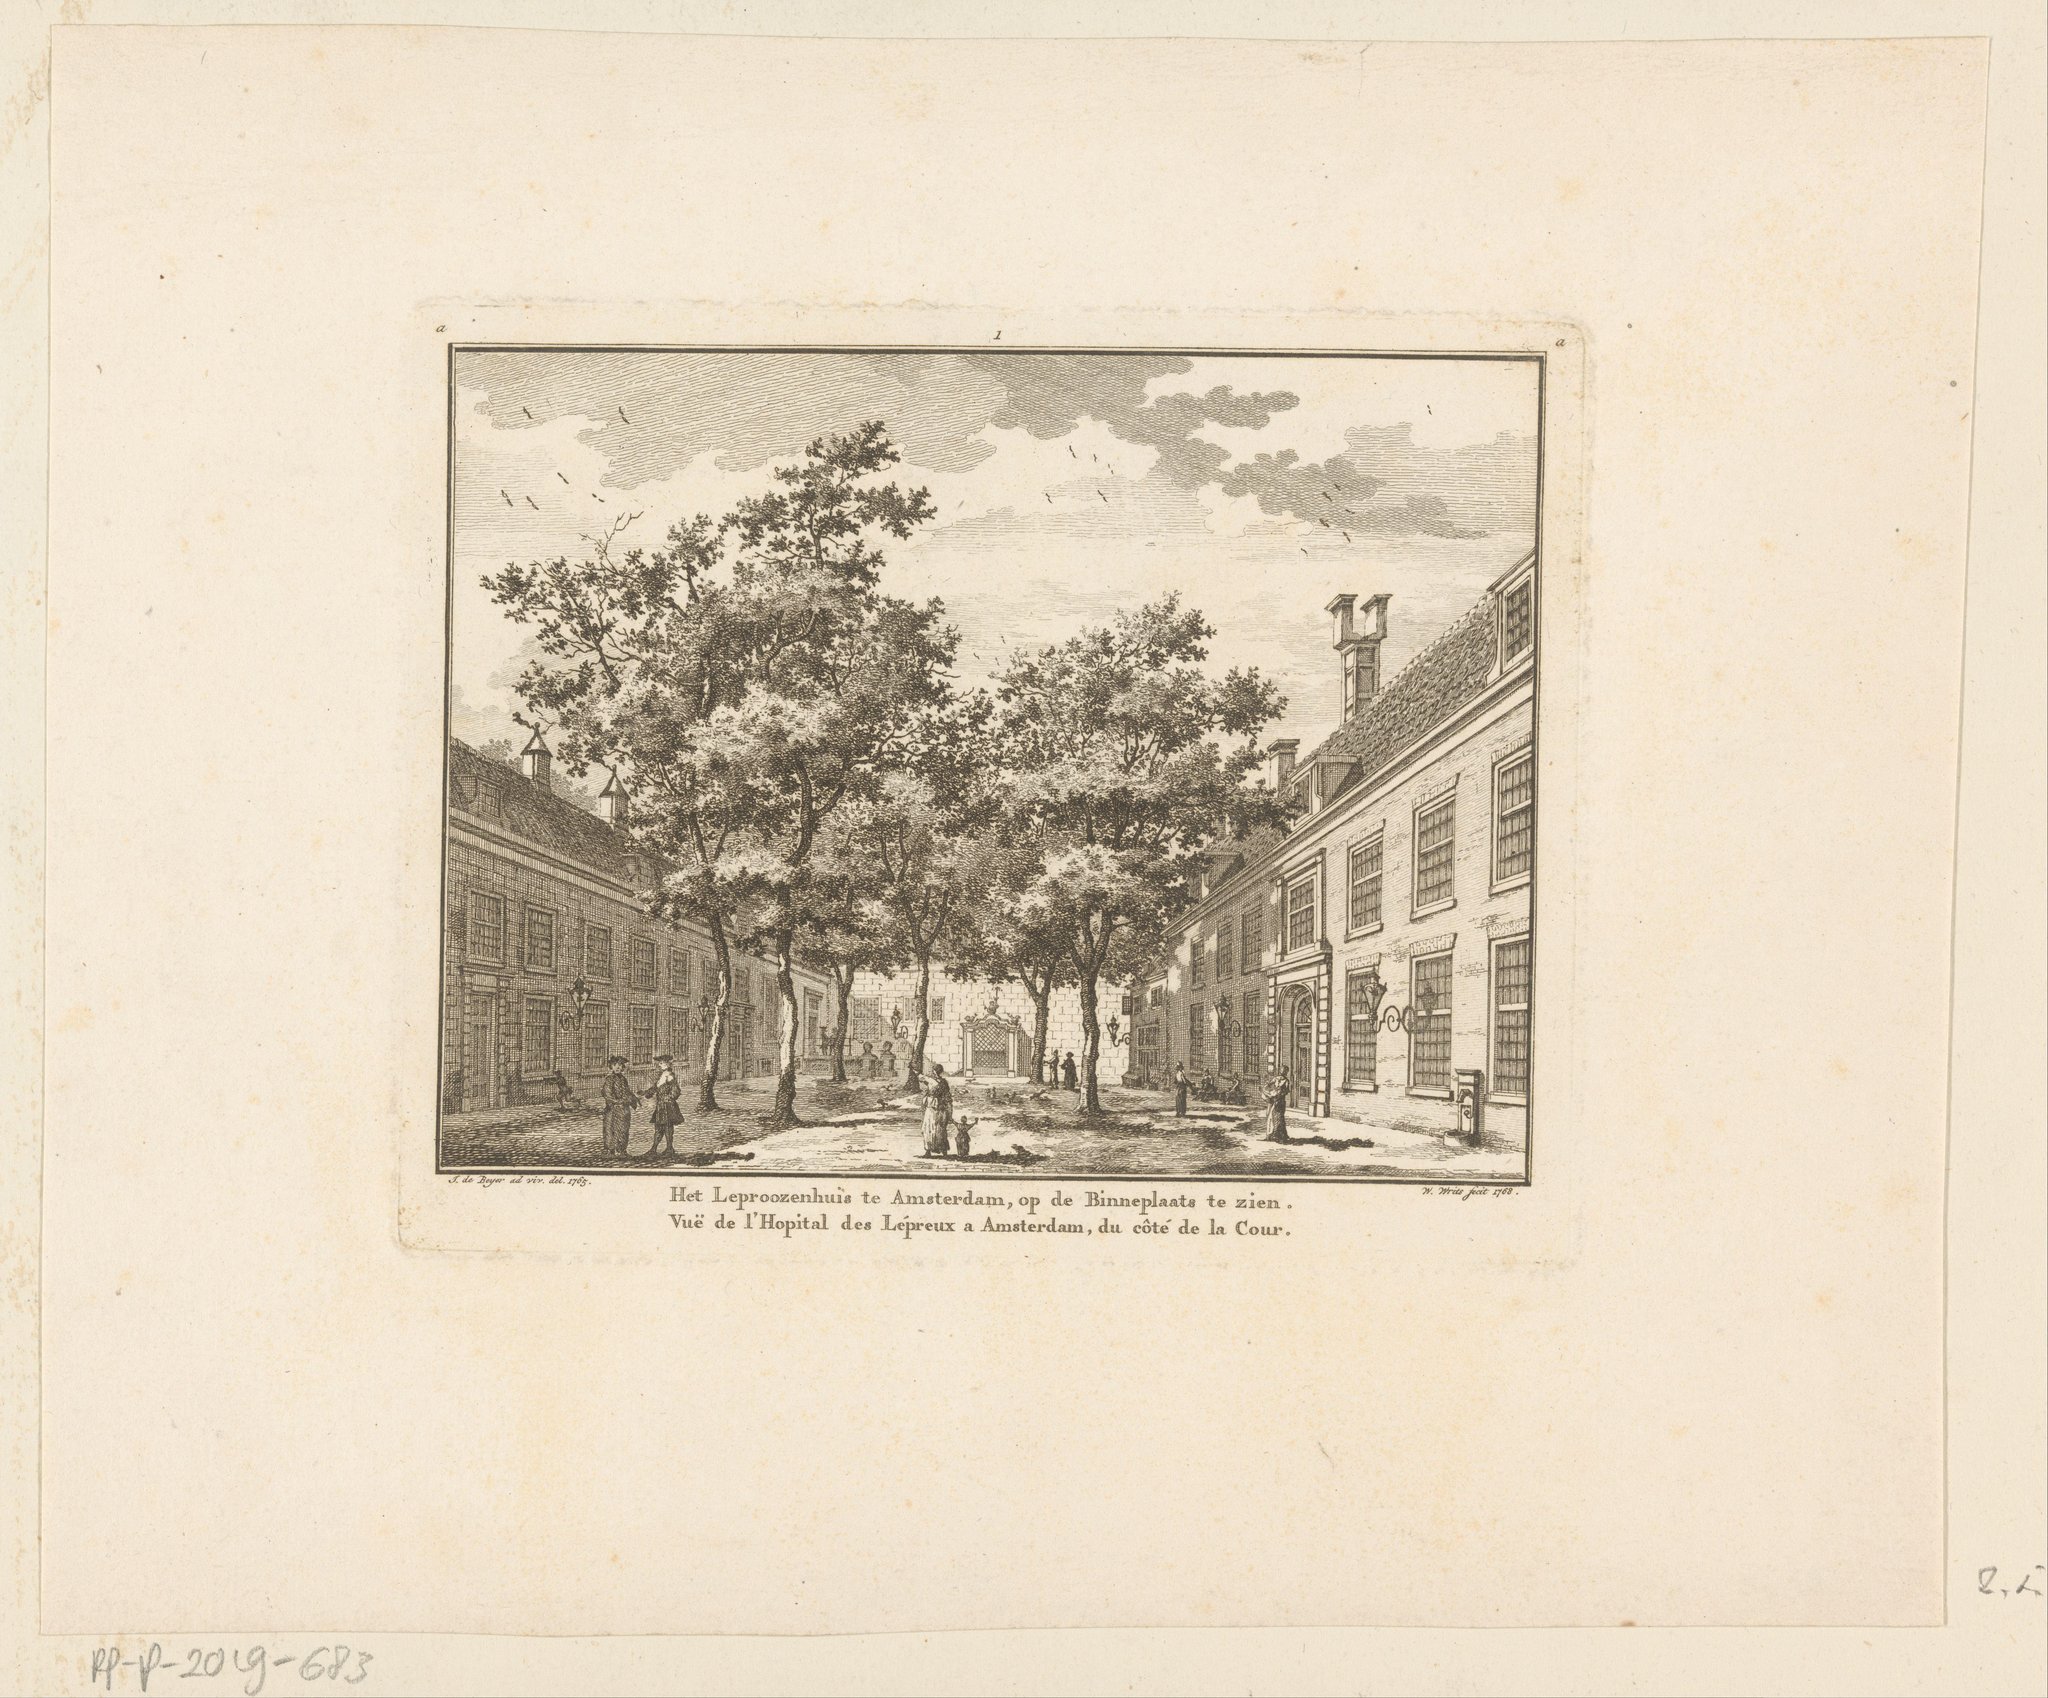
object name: print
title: Het Leproozenhuis te Amsterdam, op de Binneplaats te zien / Vuë de l'Hopital des Lépreux a Amsterdam, du côté de la Cour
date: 1768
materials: paper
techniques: etching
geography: amsterdam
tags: leprosarium, public welfare, hospital, courtyard, lunatic asylum, mental home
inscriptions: date